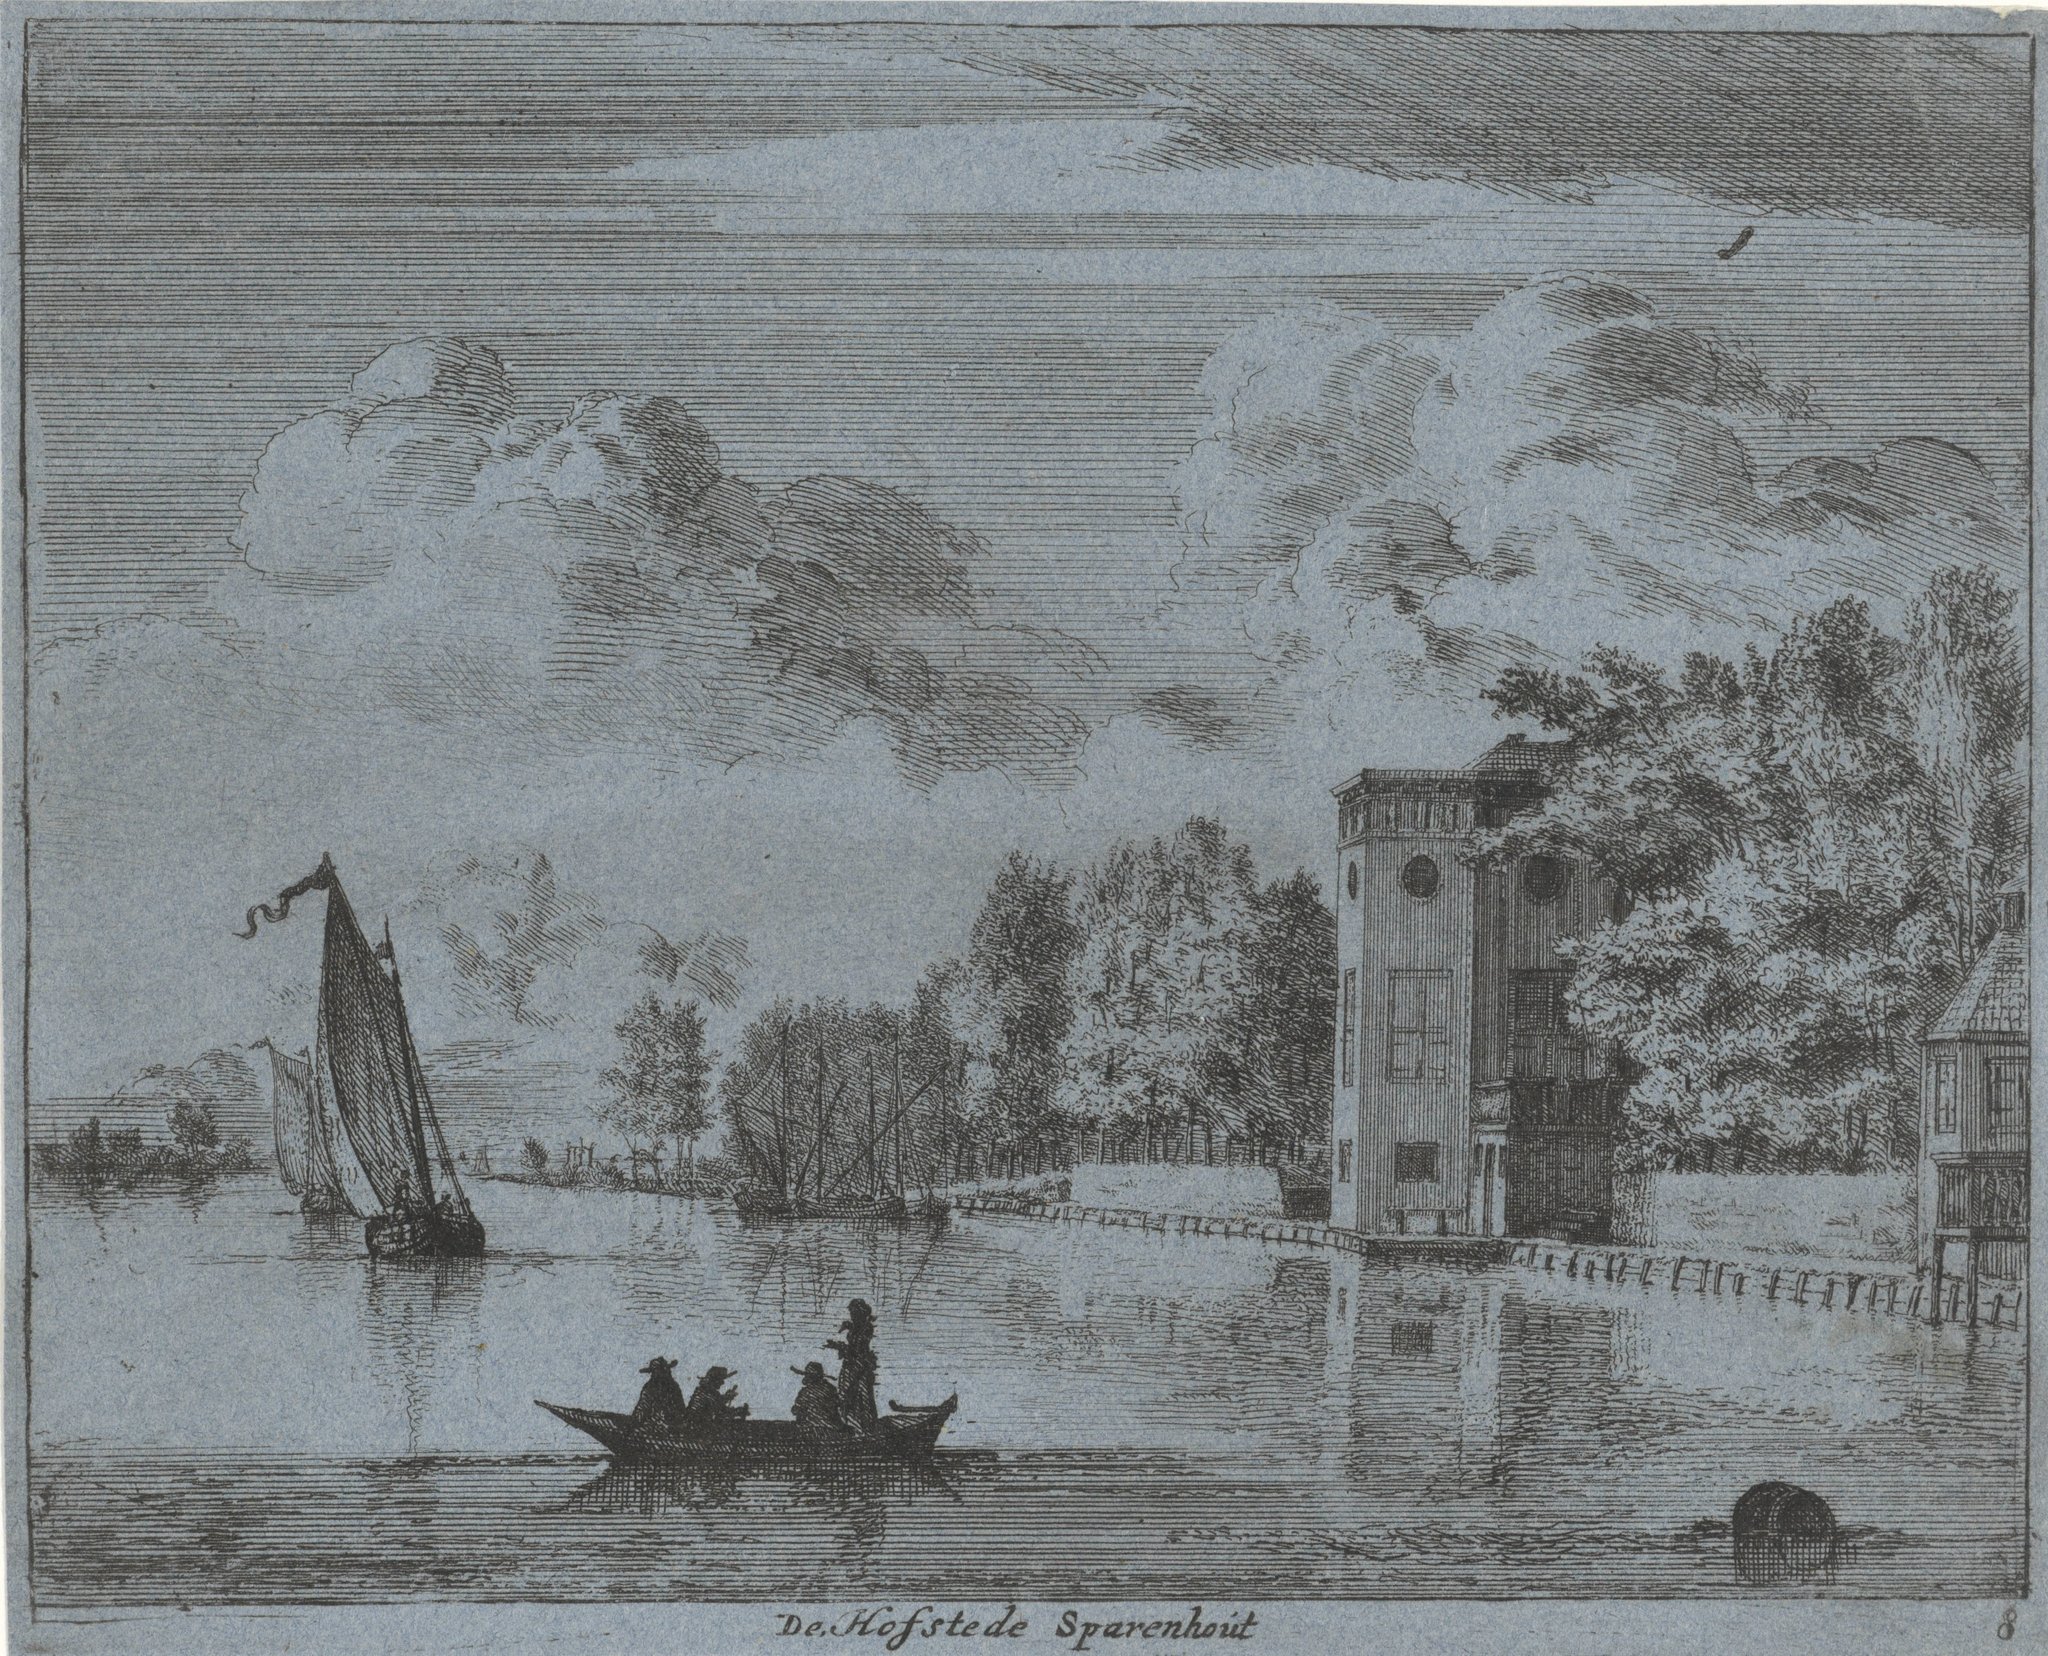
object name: print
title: De Hofstede Sparenhout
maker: jan vincentsz. van der vinne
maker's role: draughtsman, print maker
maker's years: 1663-1721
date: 1688-1690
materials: paper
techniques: etching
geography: haarlem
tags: sailing-ship, sailing-boat, landscapes (+ landscape with figures, staffage), outskirts of village (+ city(-scape) with figures, staffage)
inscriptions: collector's mark: Lugt 240, collector's mark: Lugt 699, collector's mark: Lugt 2228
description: Gezicht op de hofstede Sparenhout te Haarlem. Op het water twee zeilschepen en een roeiboot met vier figuren. Rechtsonder genummerd: 8.